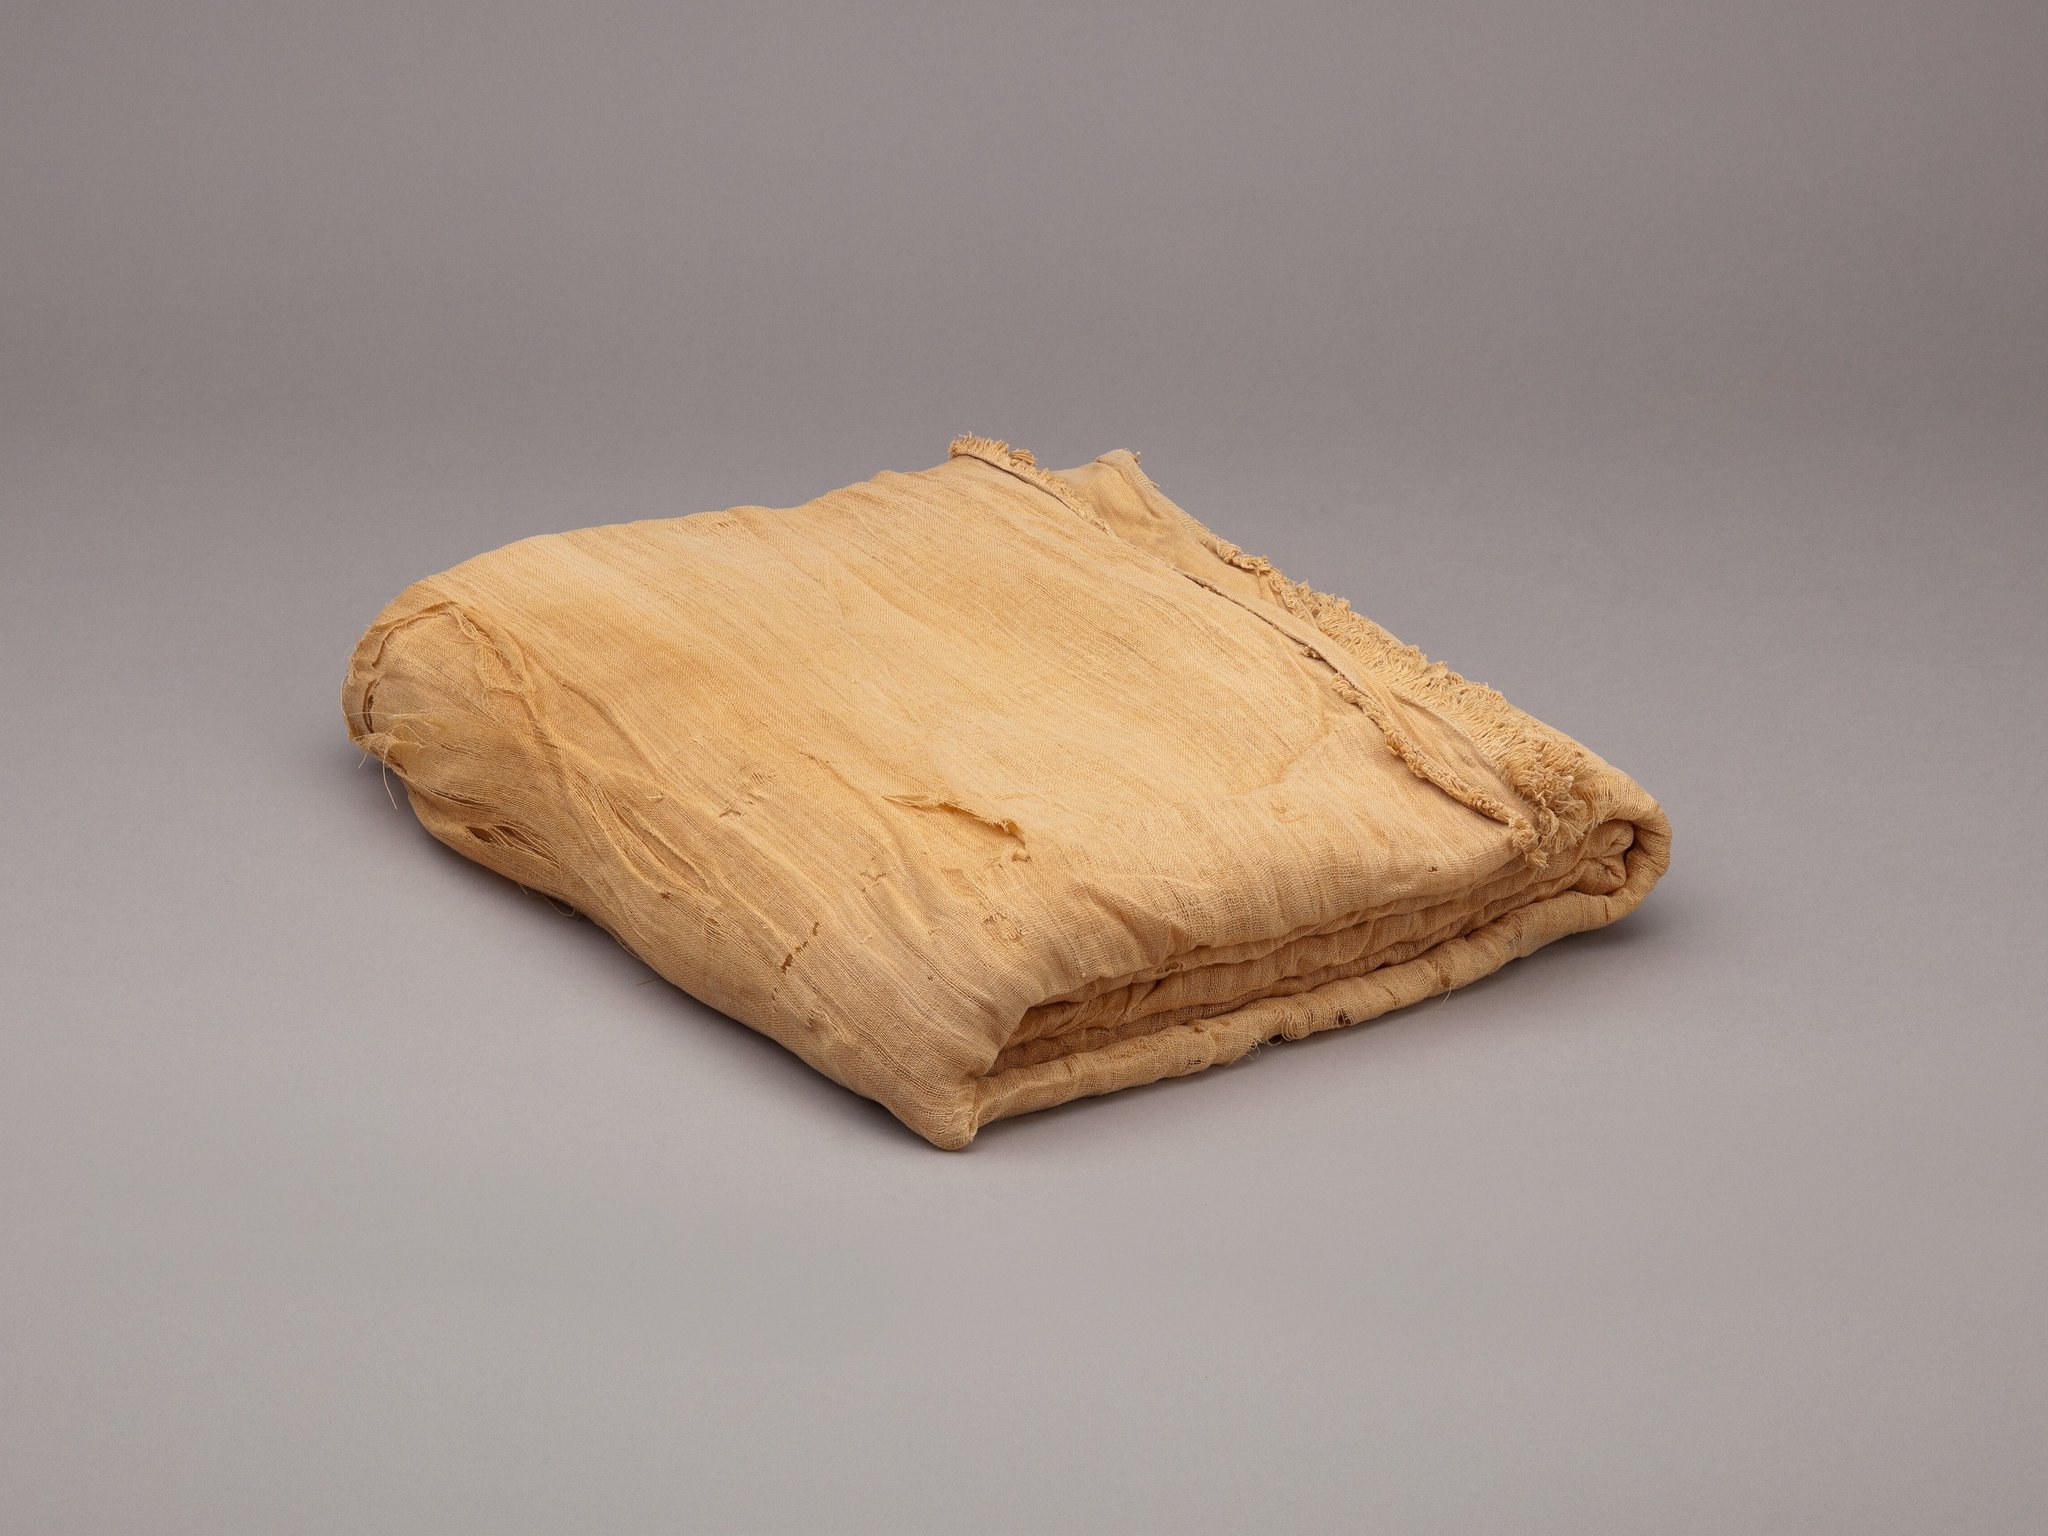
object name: linen mark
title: Sheet, linen mark, medium spin, irregular weave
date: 1492-1473 BCE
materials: linen, wax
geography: egypt